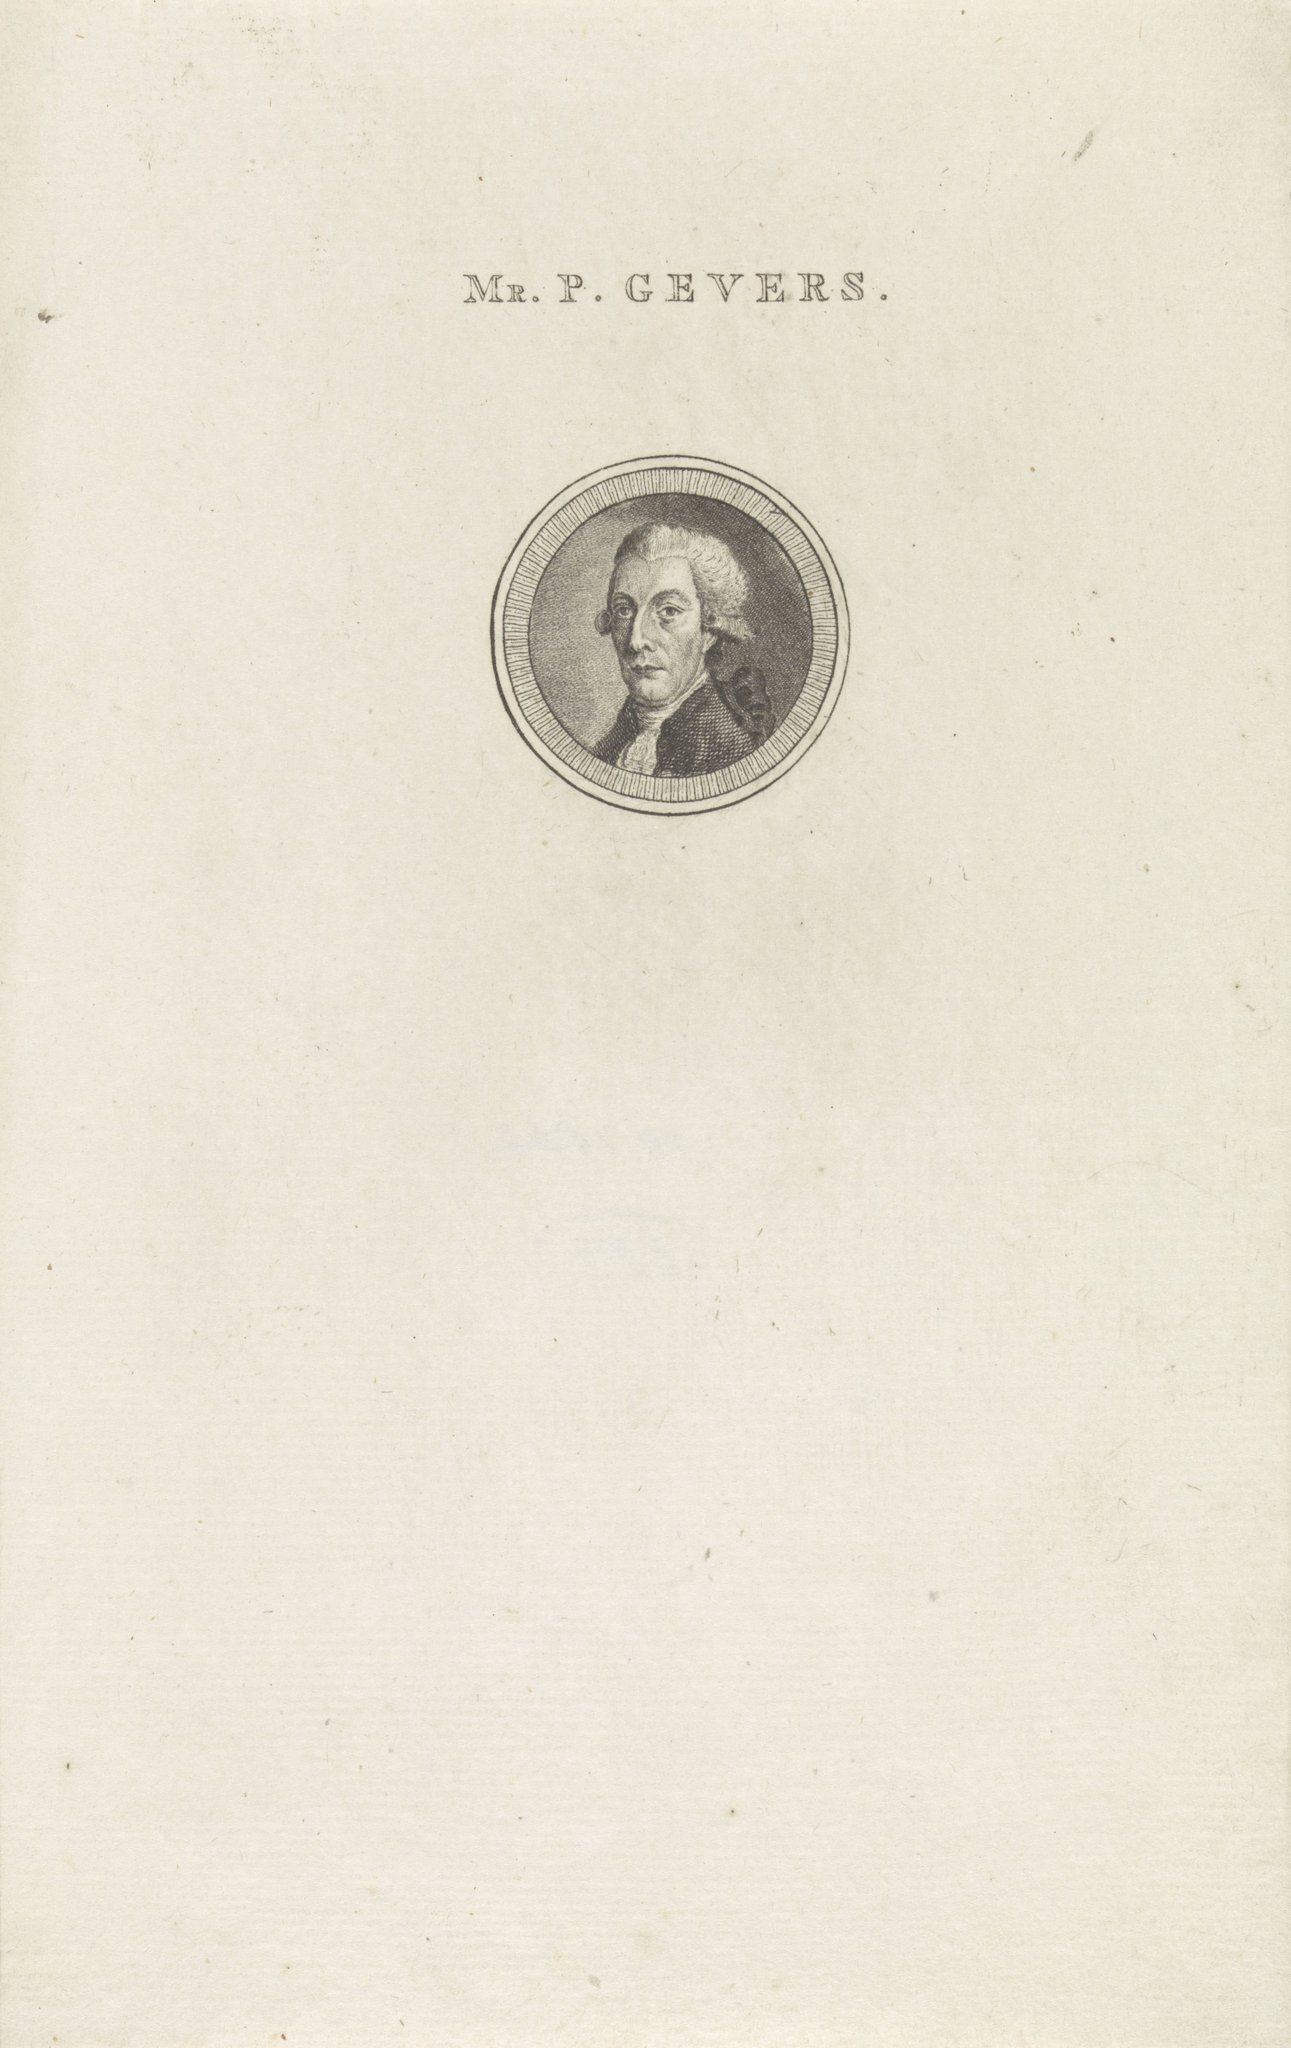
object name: print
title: Vaderlandsche Chocolaad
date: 1787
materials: paper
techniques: engraving, etching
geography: amsterdam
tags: rotterdam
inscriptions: collector's mark: Lugt 2228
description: Jacobus Wijsman heeft sommige platen van de serie patriottenportretten van Abraham Jacobsz. Hulk aangepast en hergebruikt in zijn eigen serie patriottenportretten.